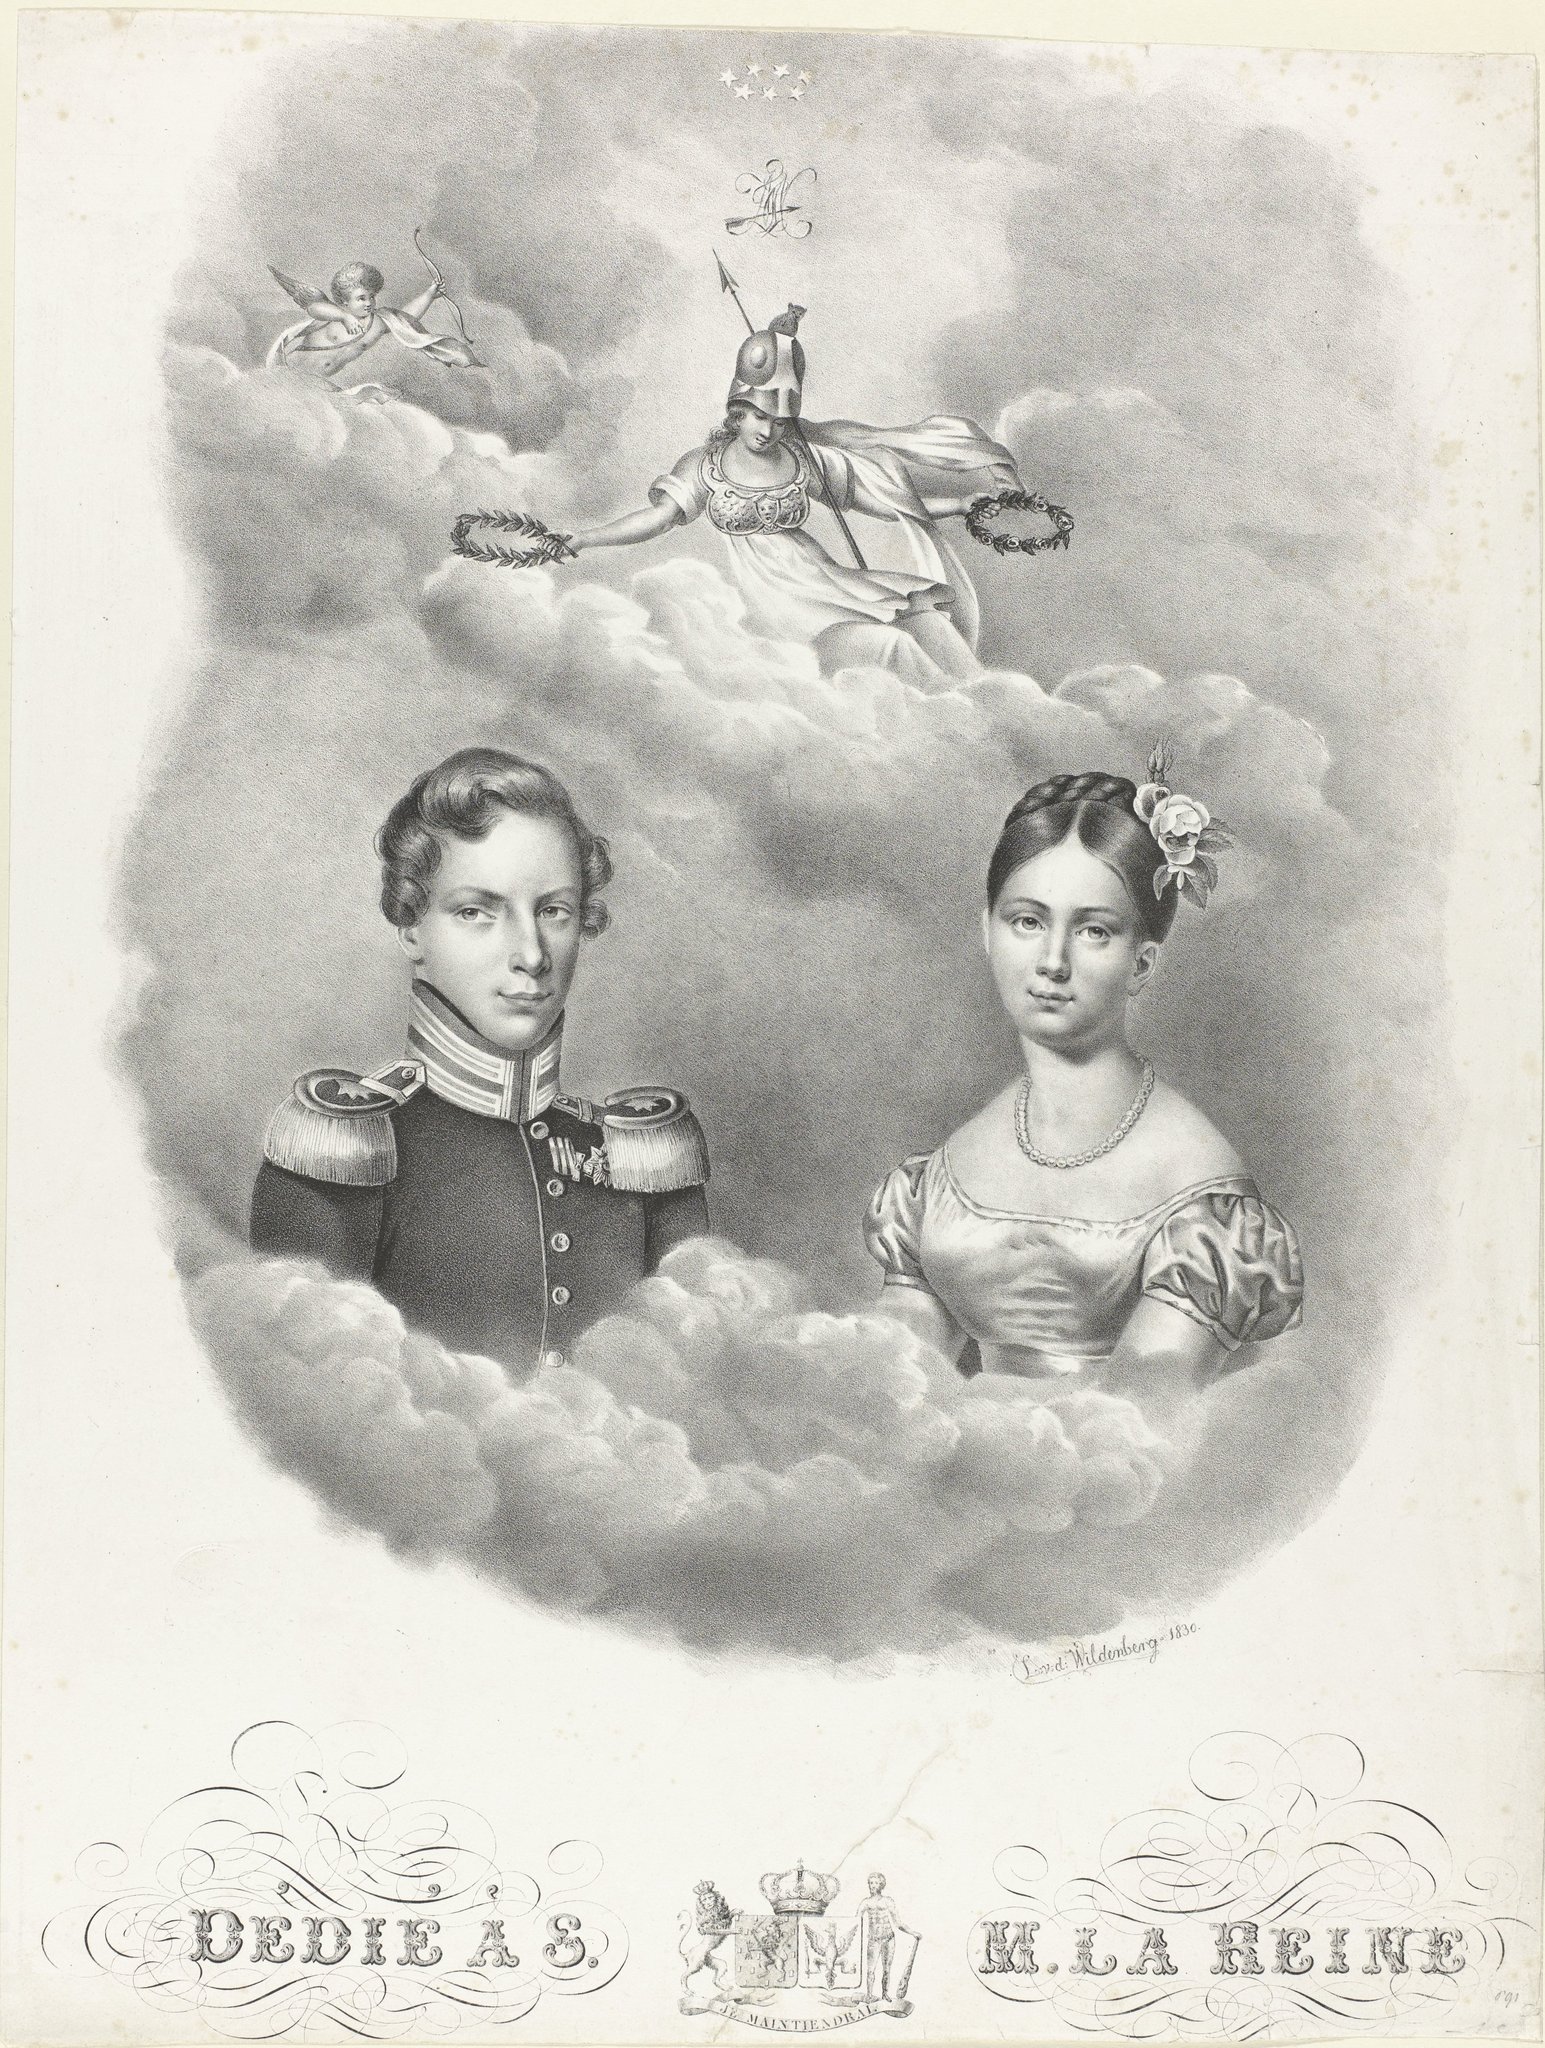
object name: print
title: Portret van Marianne, prinses der Nederlanden, en Albert van Pruisen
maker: l. van de wildenberg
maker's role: print maker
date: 1830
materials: paper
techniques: lithograph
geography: brussels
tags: berlin, voorburg, marianne (prinses der nederlanden)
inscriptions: check stamp: ‘EDITEUR ...’, collector's mark: Lugt 963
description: Portret van Marianne en Albert van Pruisen. Ze zijn omringd door wolken. Midden boven een allegorisch figuur met een lauwerkrans en een rozenkrans. Links schiet een allegorisch figuur een pijl door hun initialen. Midden onder hun wapens met een kroon, een leeuw en Hercules. Daaronder op een banderol haar geslachtsspreuk. In de ondermarge een regel Franse tekst.